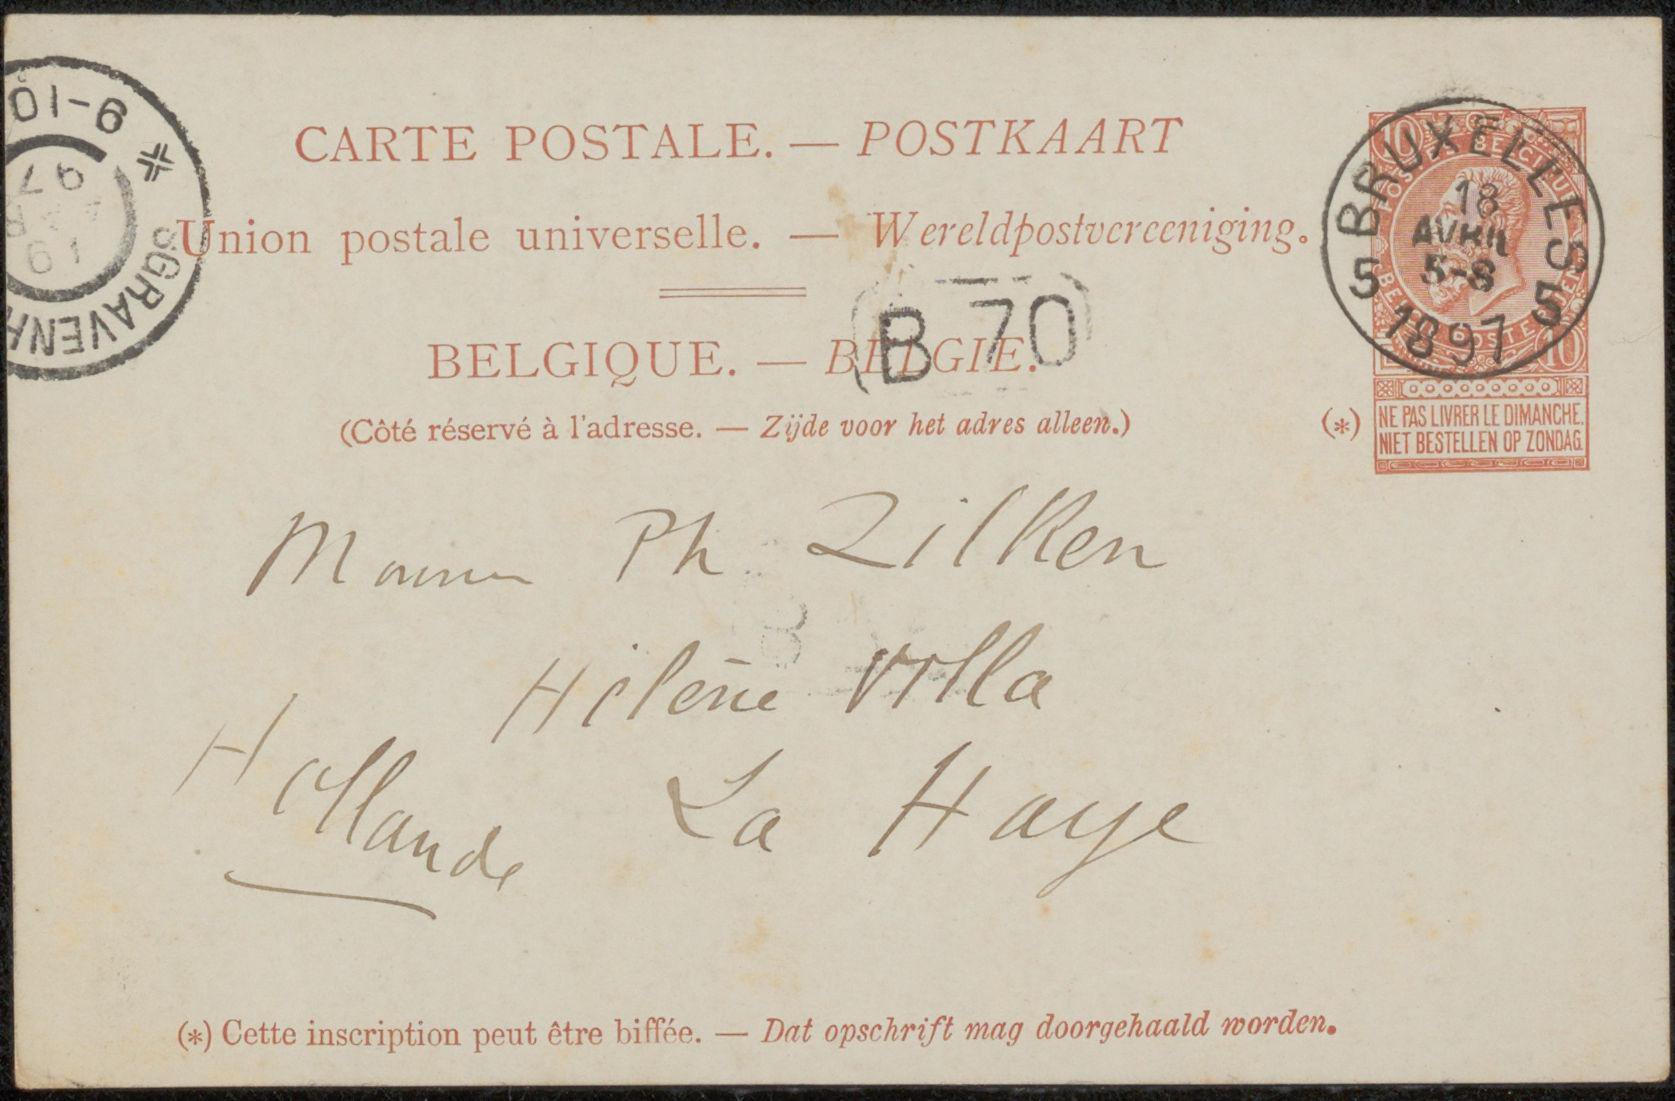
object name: postcard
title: Briefkaart aan Philip Zilcken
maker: burggraaf de colleville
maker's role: burggraaf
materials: cardboard, ink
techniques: pen, writing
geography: brussels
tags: the hague, painter, draughtsman, philip zilcken, amsterdam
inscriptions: collector's mark: ‘RPK’